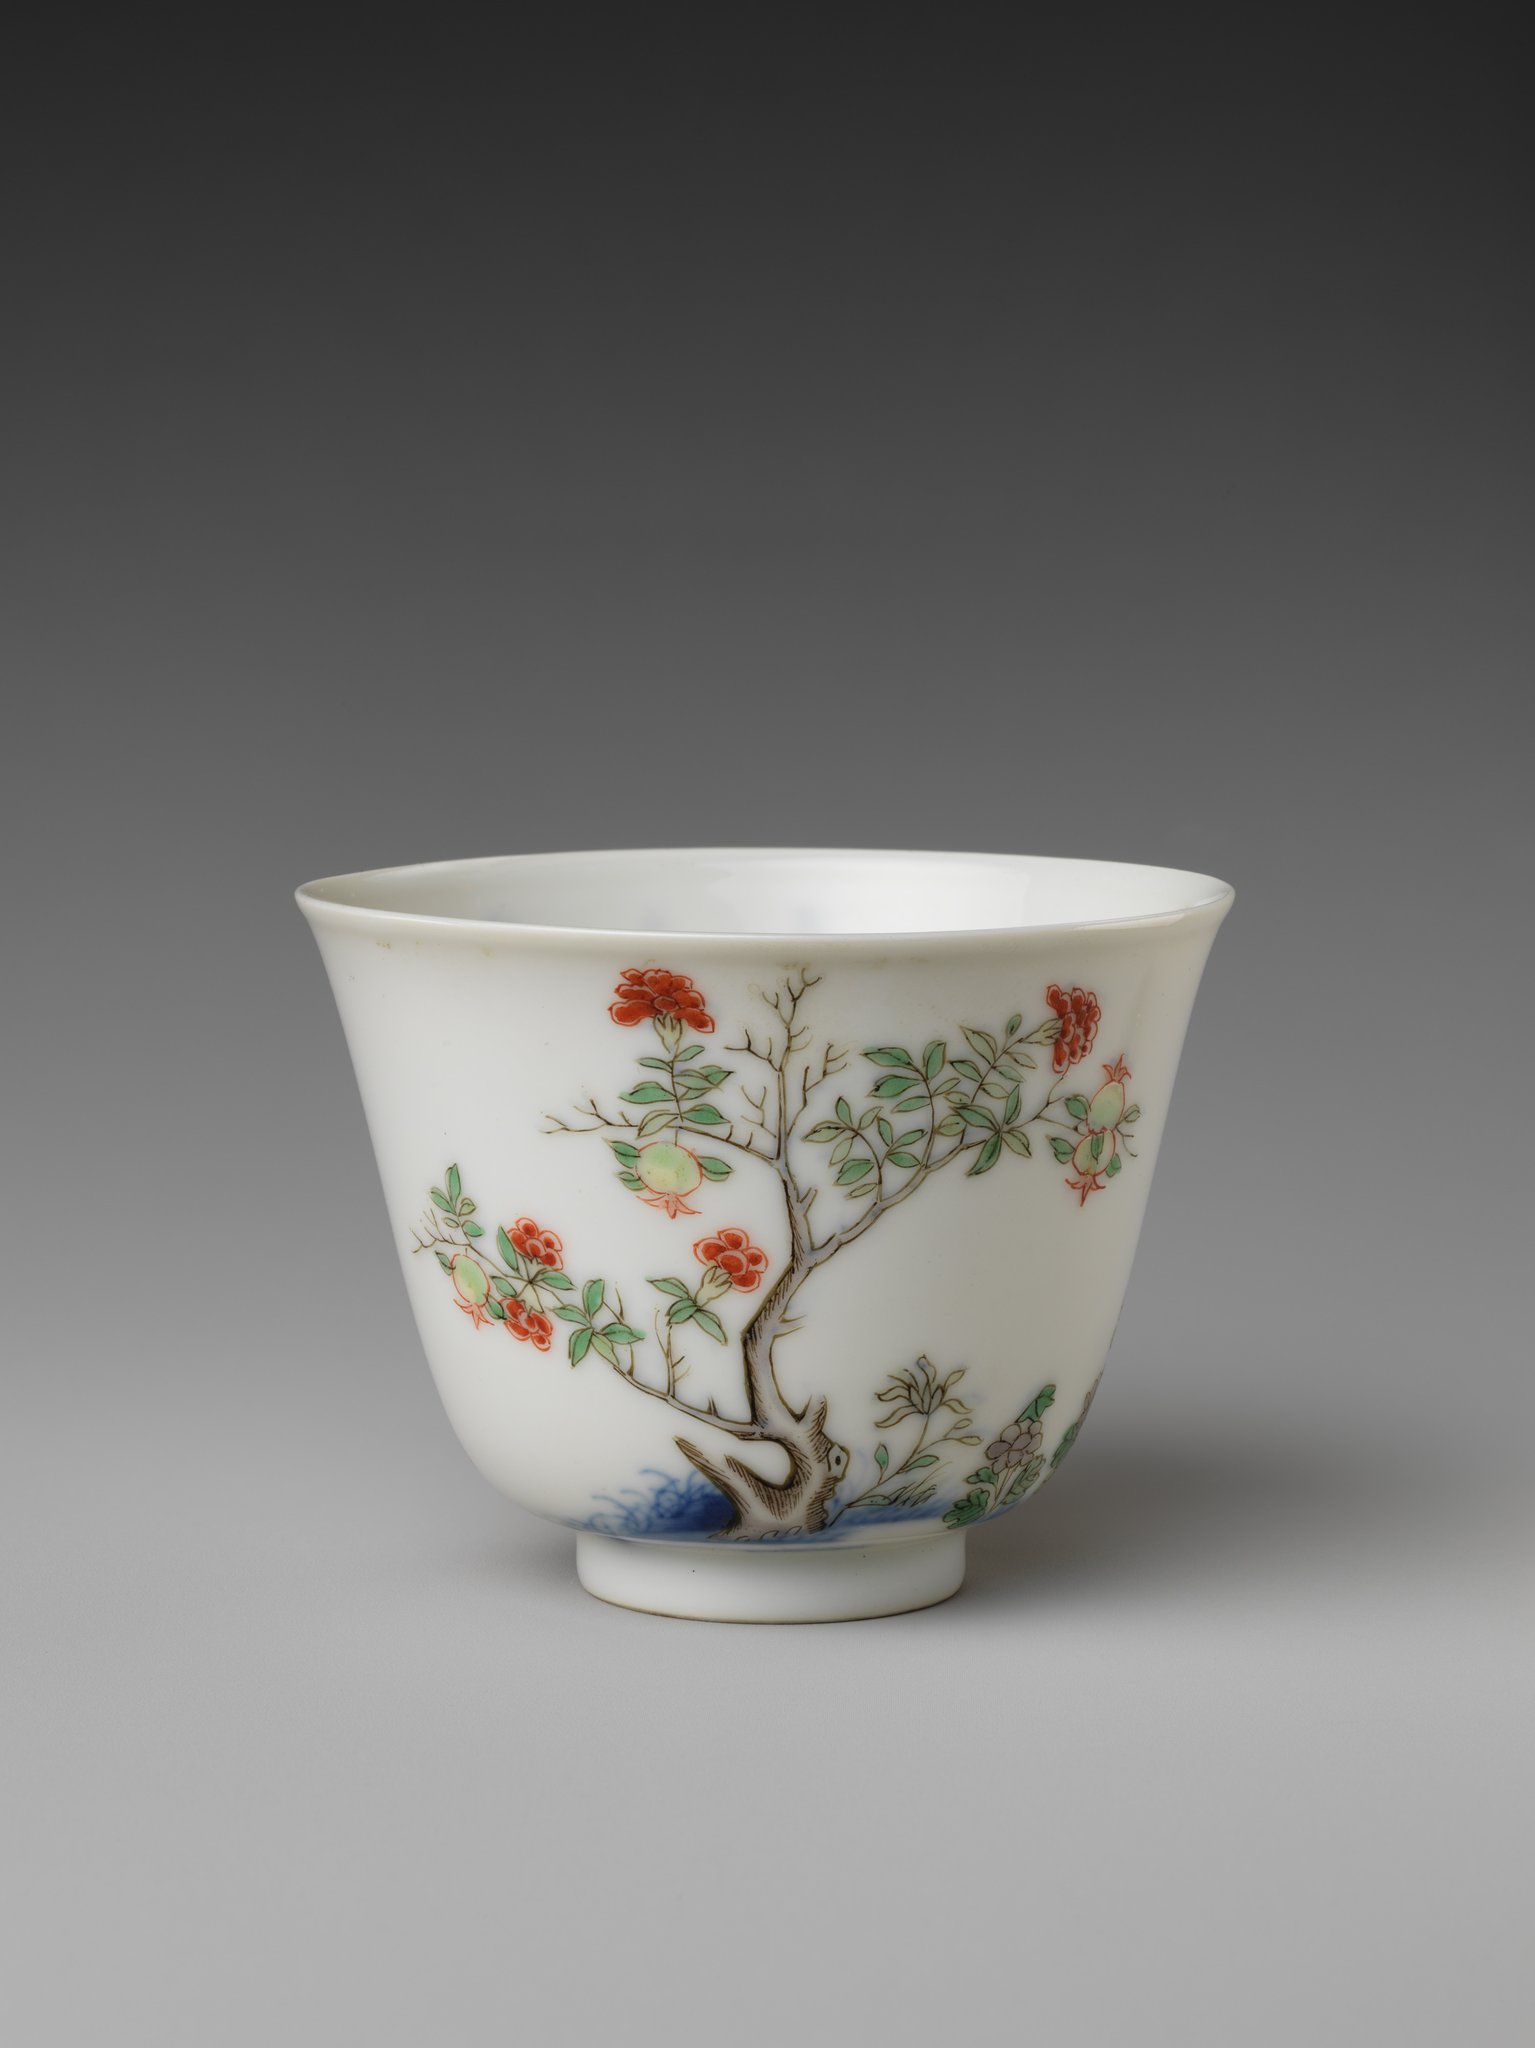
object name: cup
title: Monthly flower cup (from set of twelve)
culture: chinese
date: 1701-1733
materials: cobalt, enamel, porcelain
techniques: overglaze, painting, polychrome, underglaze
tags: flowers